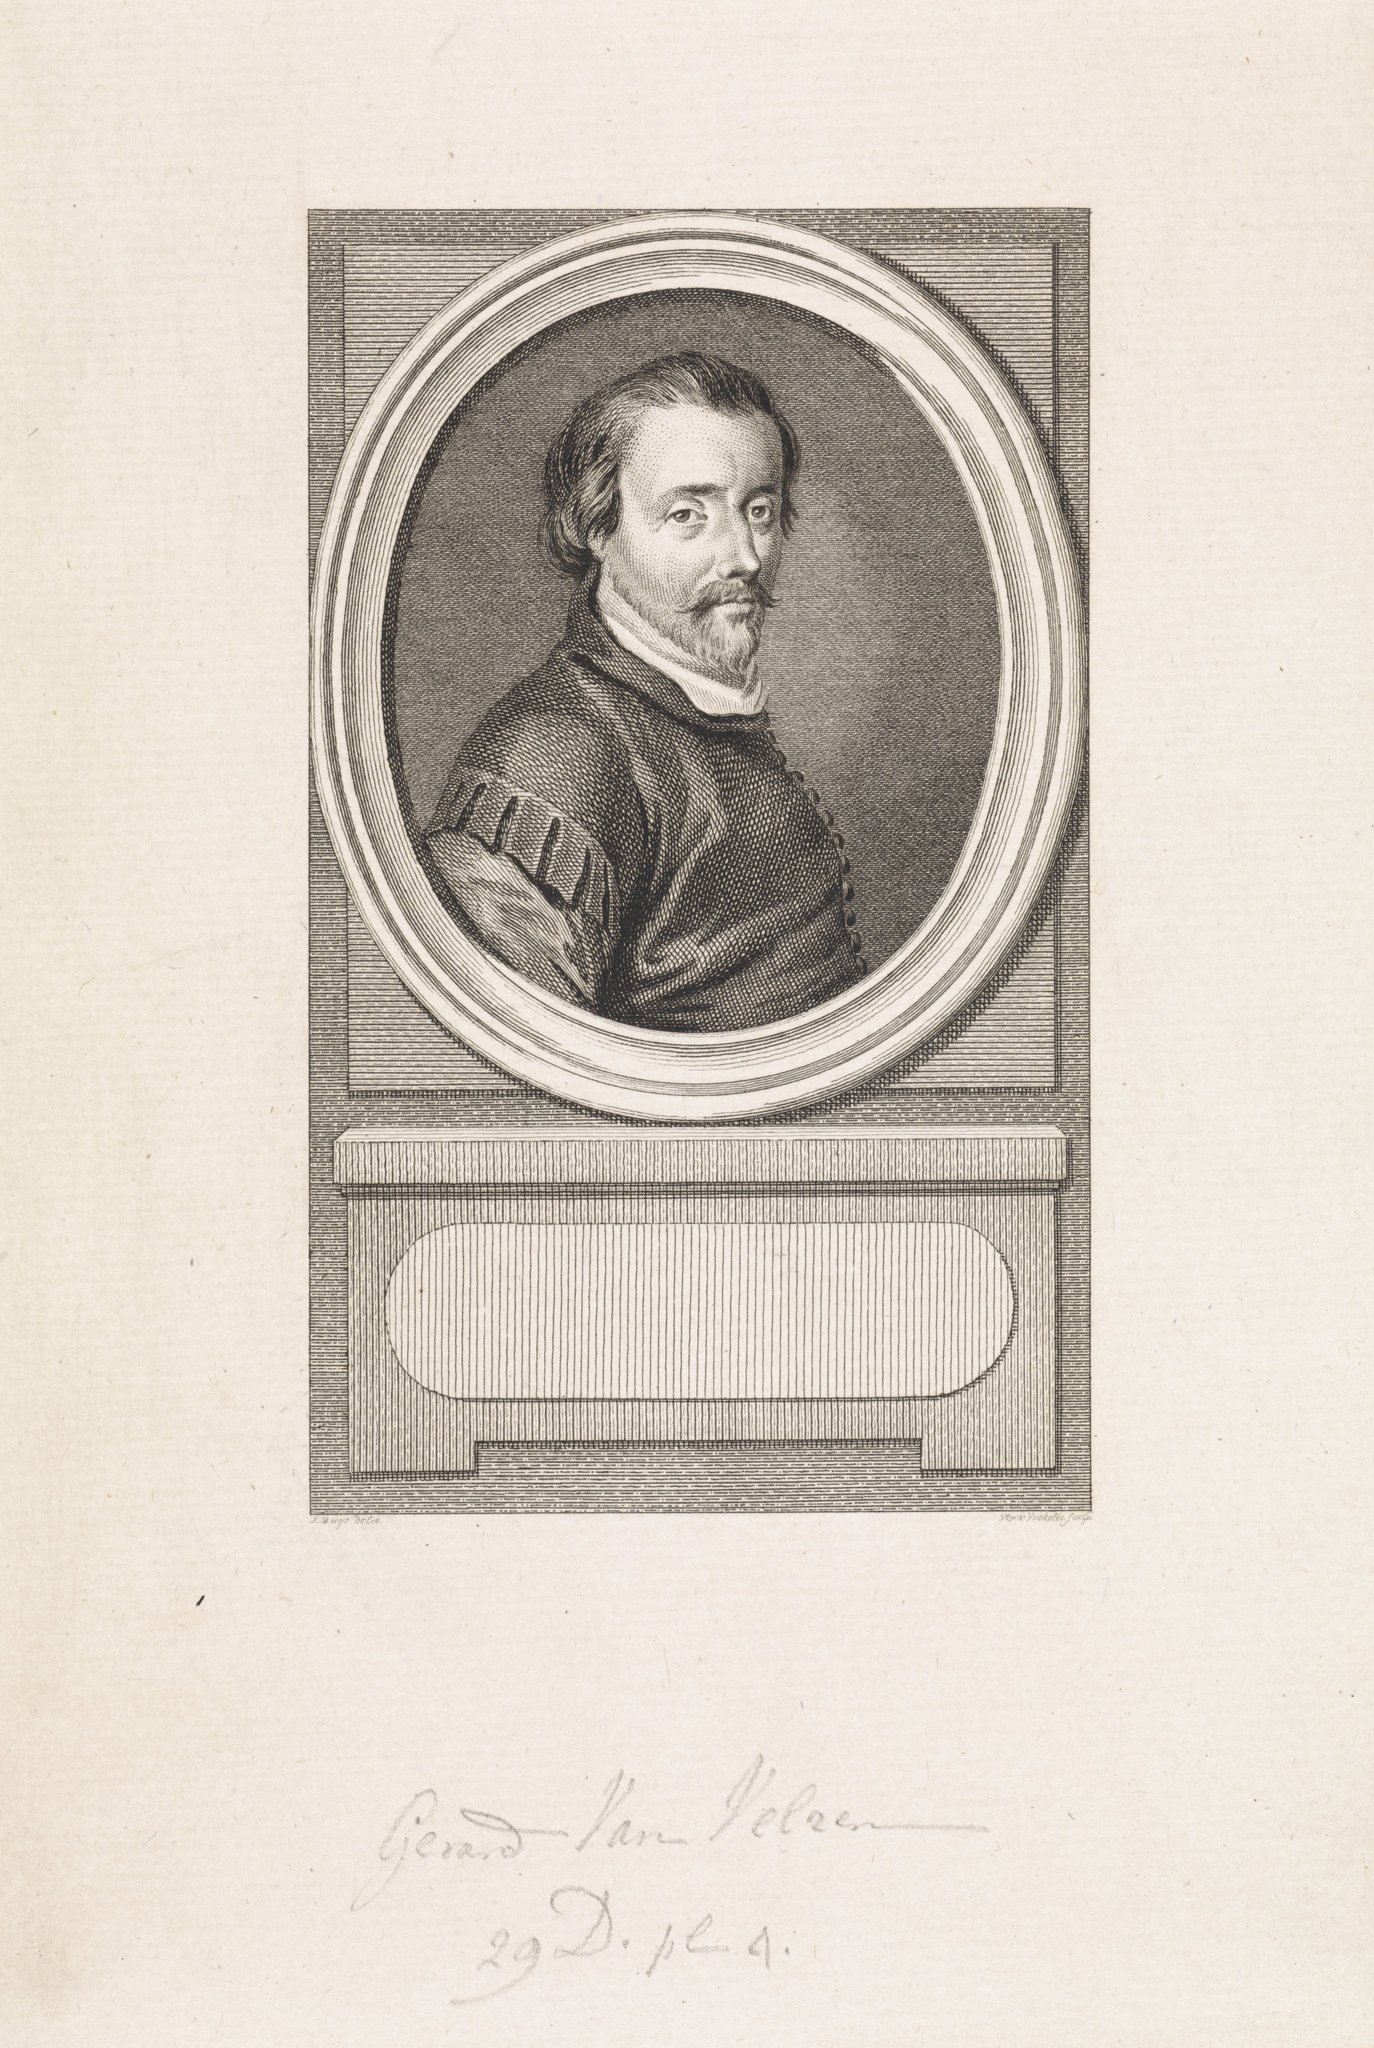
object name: print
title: Portret van Gerard van Velzen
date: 1793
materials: paper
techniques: engraving, etching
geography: amsterdam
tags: gerard van velzen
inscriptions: collector's mark: Lugt 2228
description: Latere staat prent gebruikt als boekillustratie in: Kok, Jacobus. Vaderlandsch woordenboek : met kaarten, plaaten en pourtraitten. Amsterdam: Johannes Allart, 1785-1796. Deel XXIX.